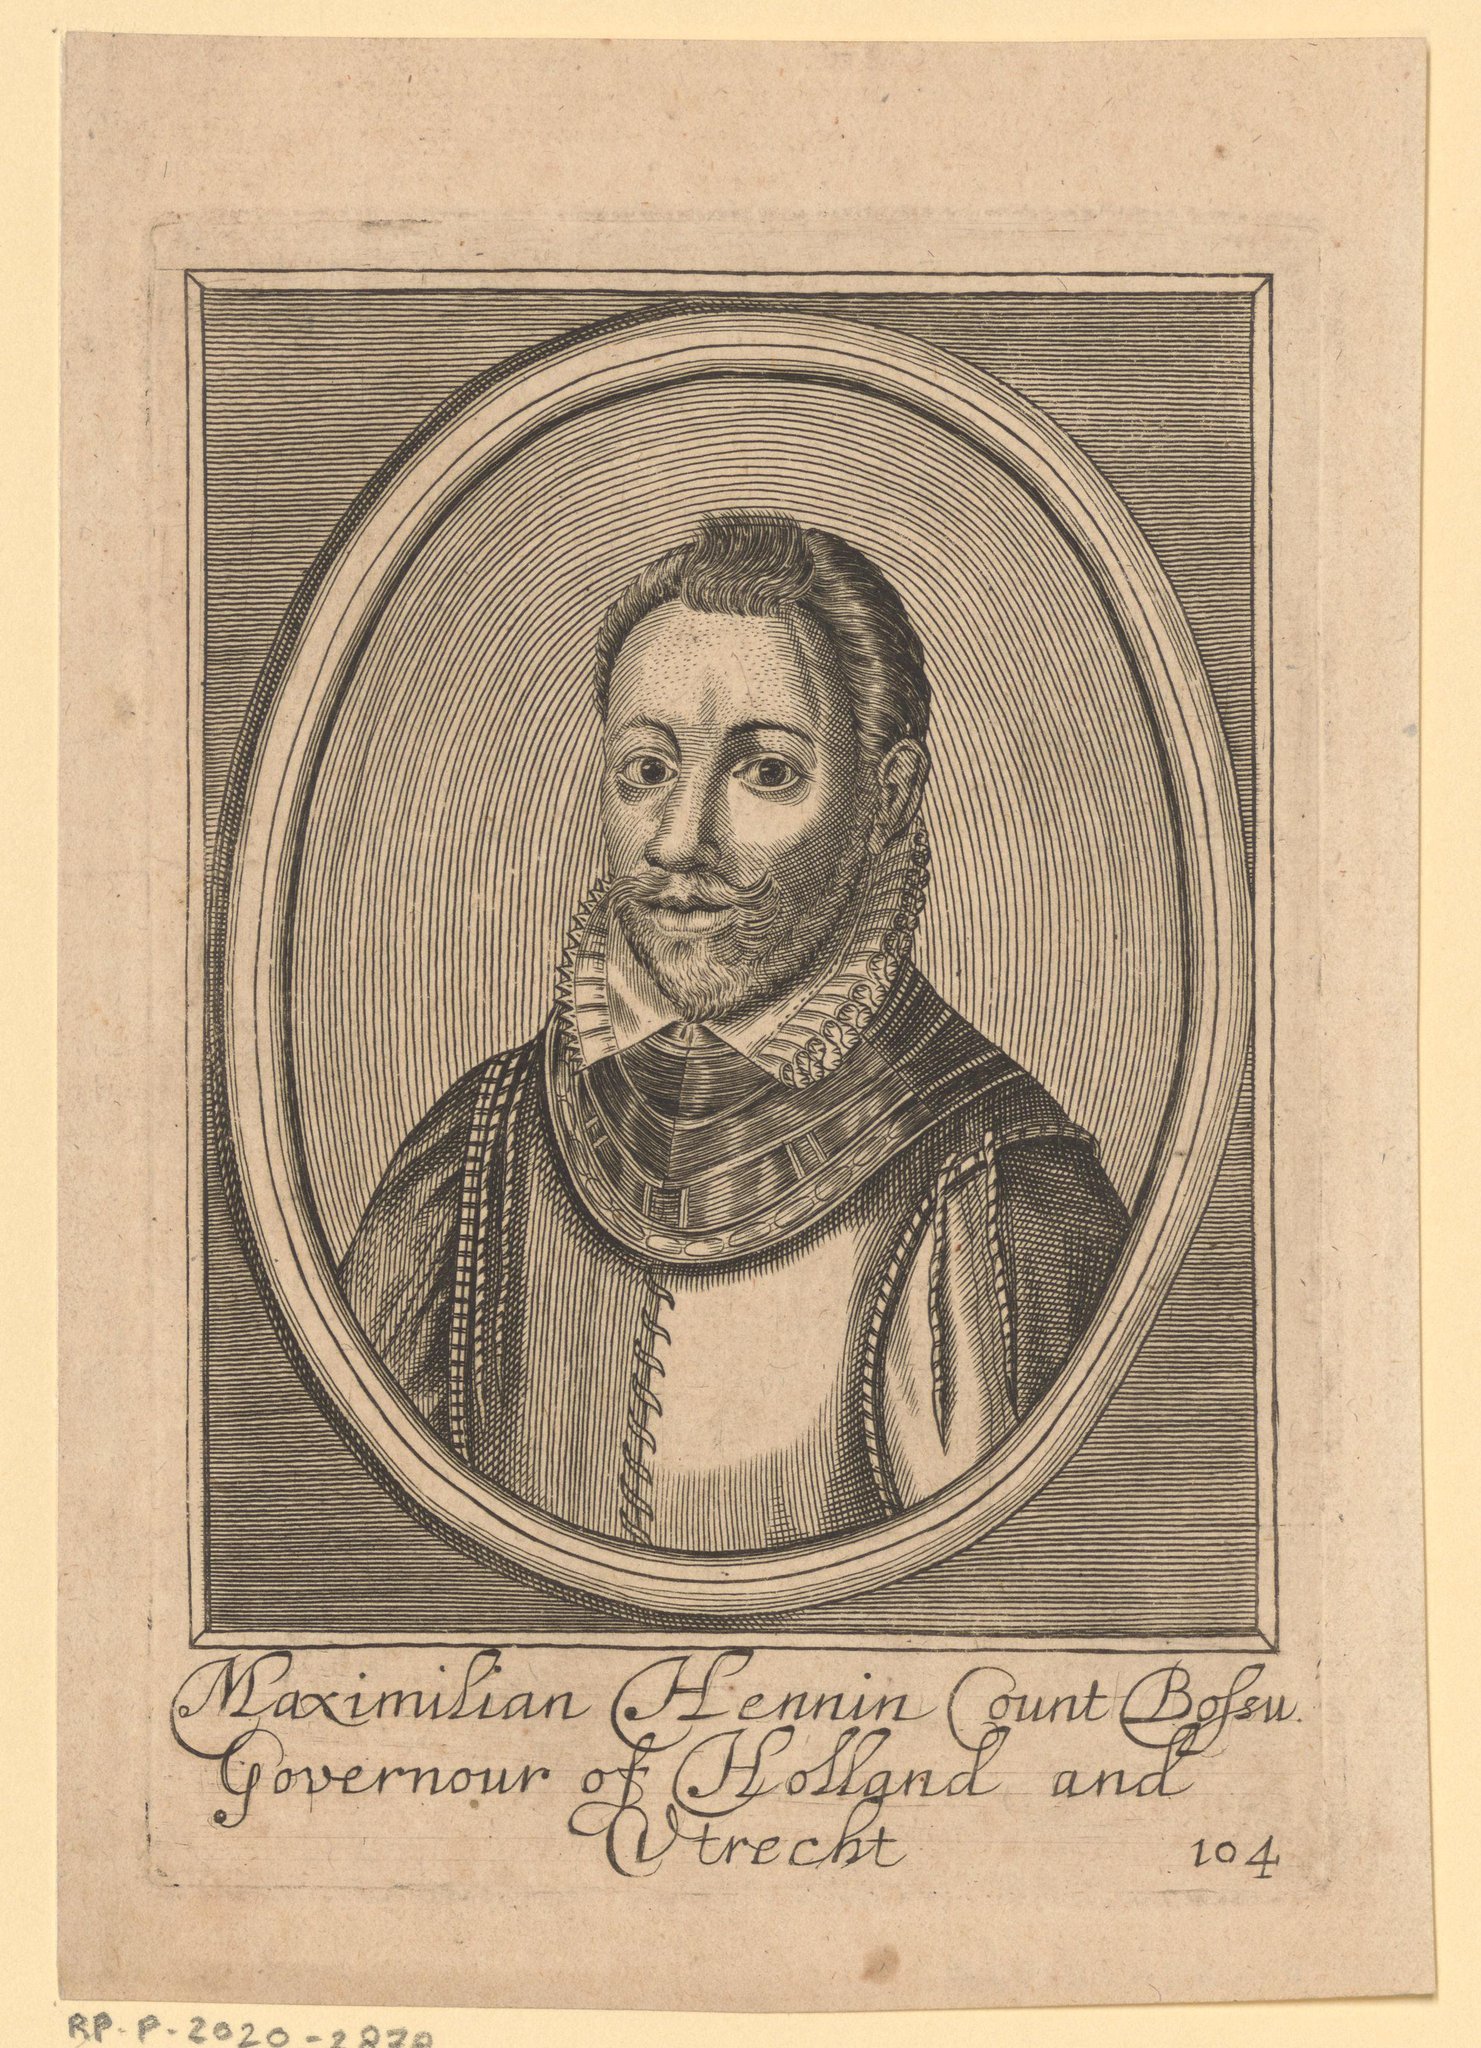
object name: print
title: Portret van Maximiliaan, graaf van Hennin-Lietard en Boussu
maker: Anonymous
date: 1600-1699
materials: paper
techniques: engraving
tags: antwerp, earl, armour, historical persons